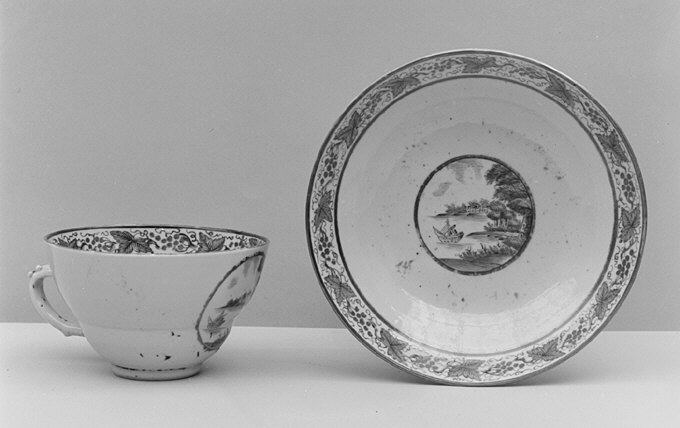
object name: cup and saucer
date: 1767-1800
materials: hard paste porcelain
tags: landscapes,ships